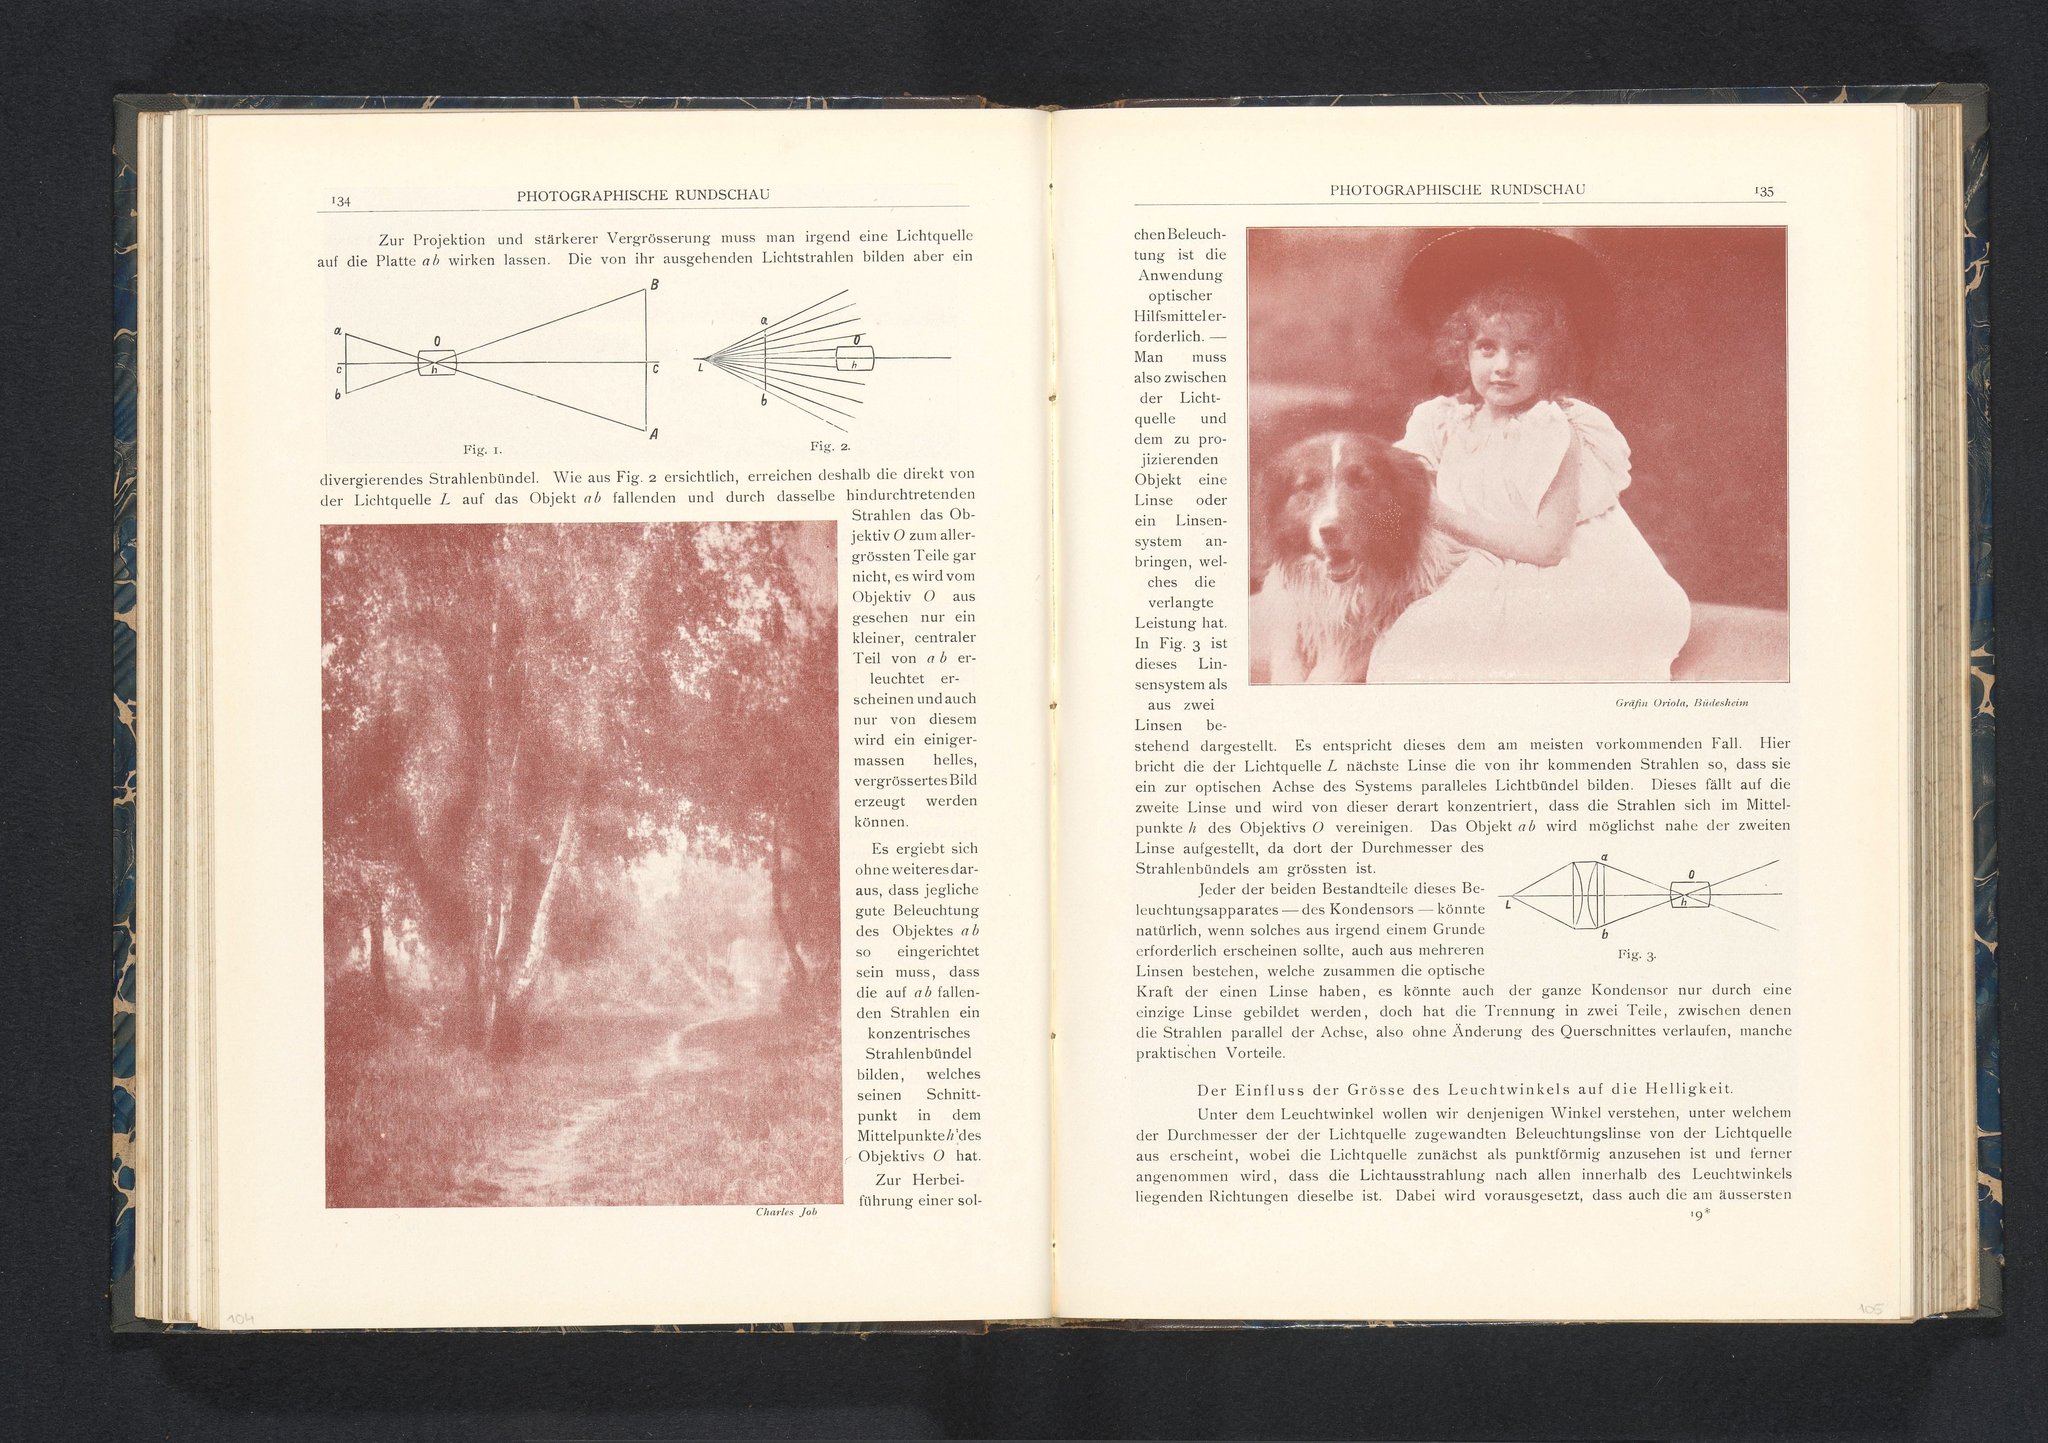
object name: photomechanical print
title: Gezicht op een bosweg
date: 1896-1901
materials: paper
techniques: autotype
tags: road, path, forest, wood